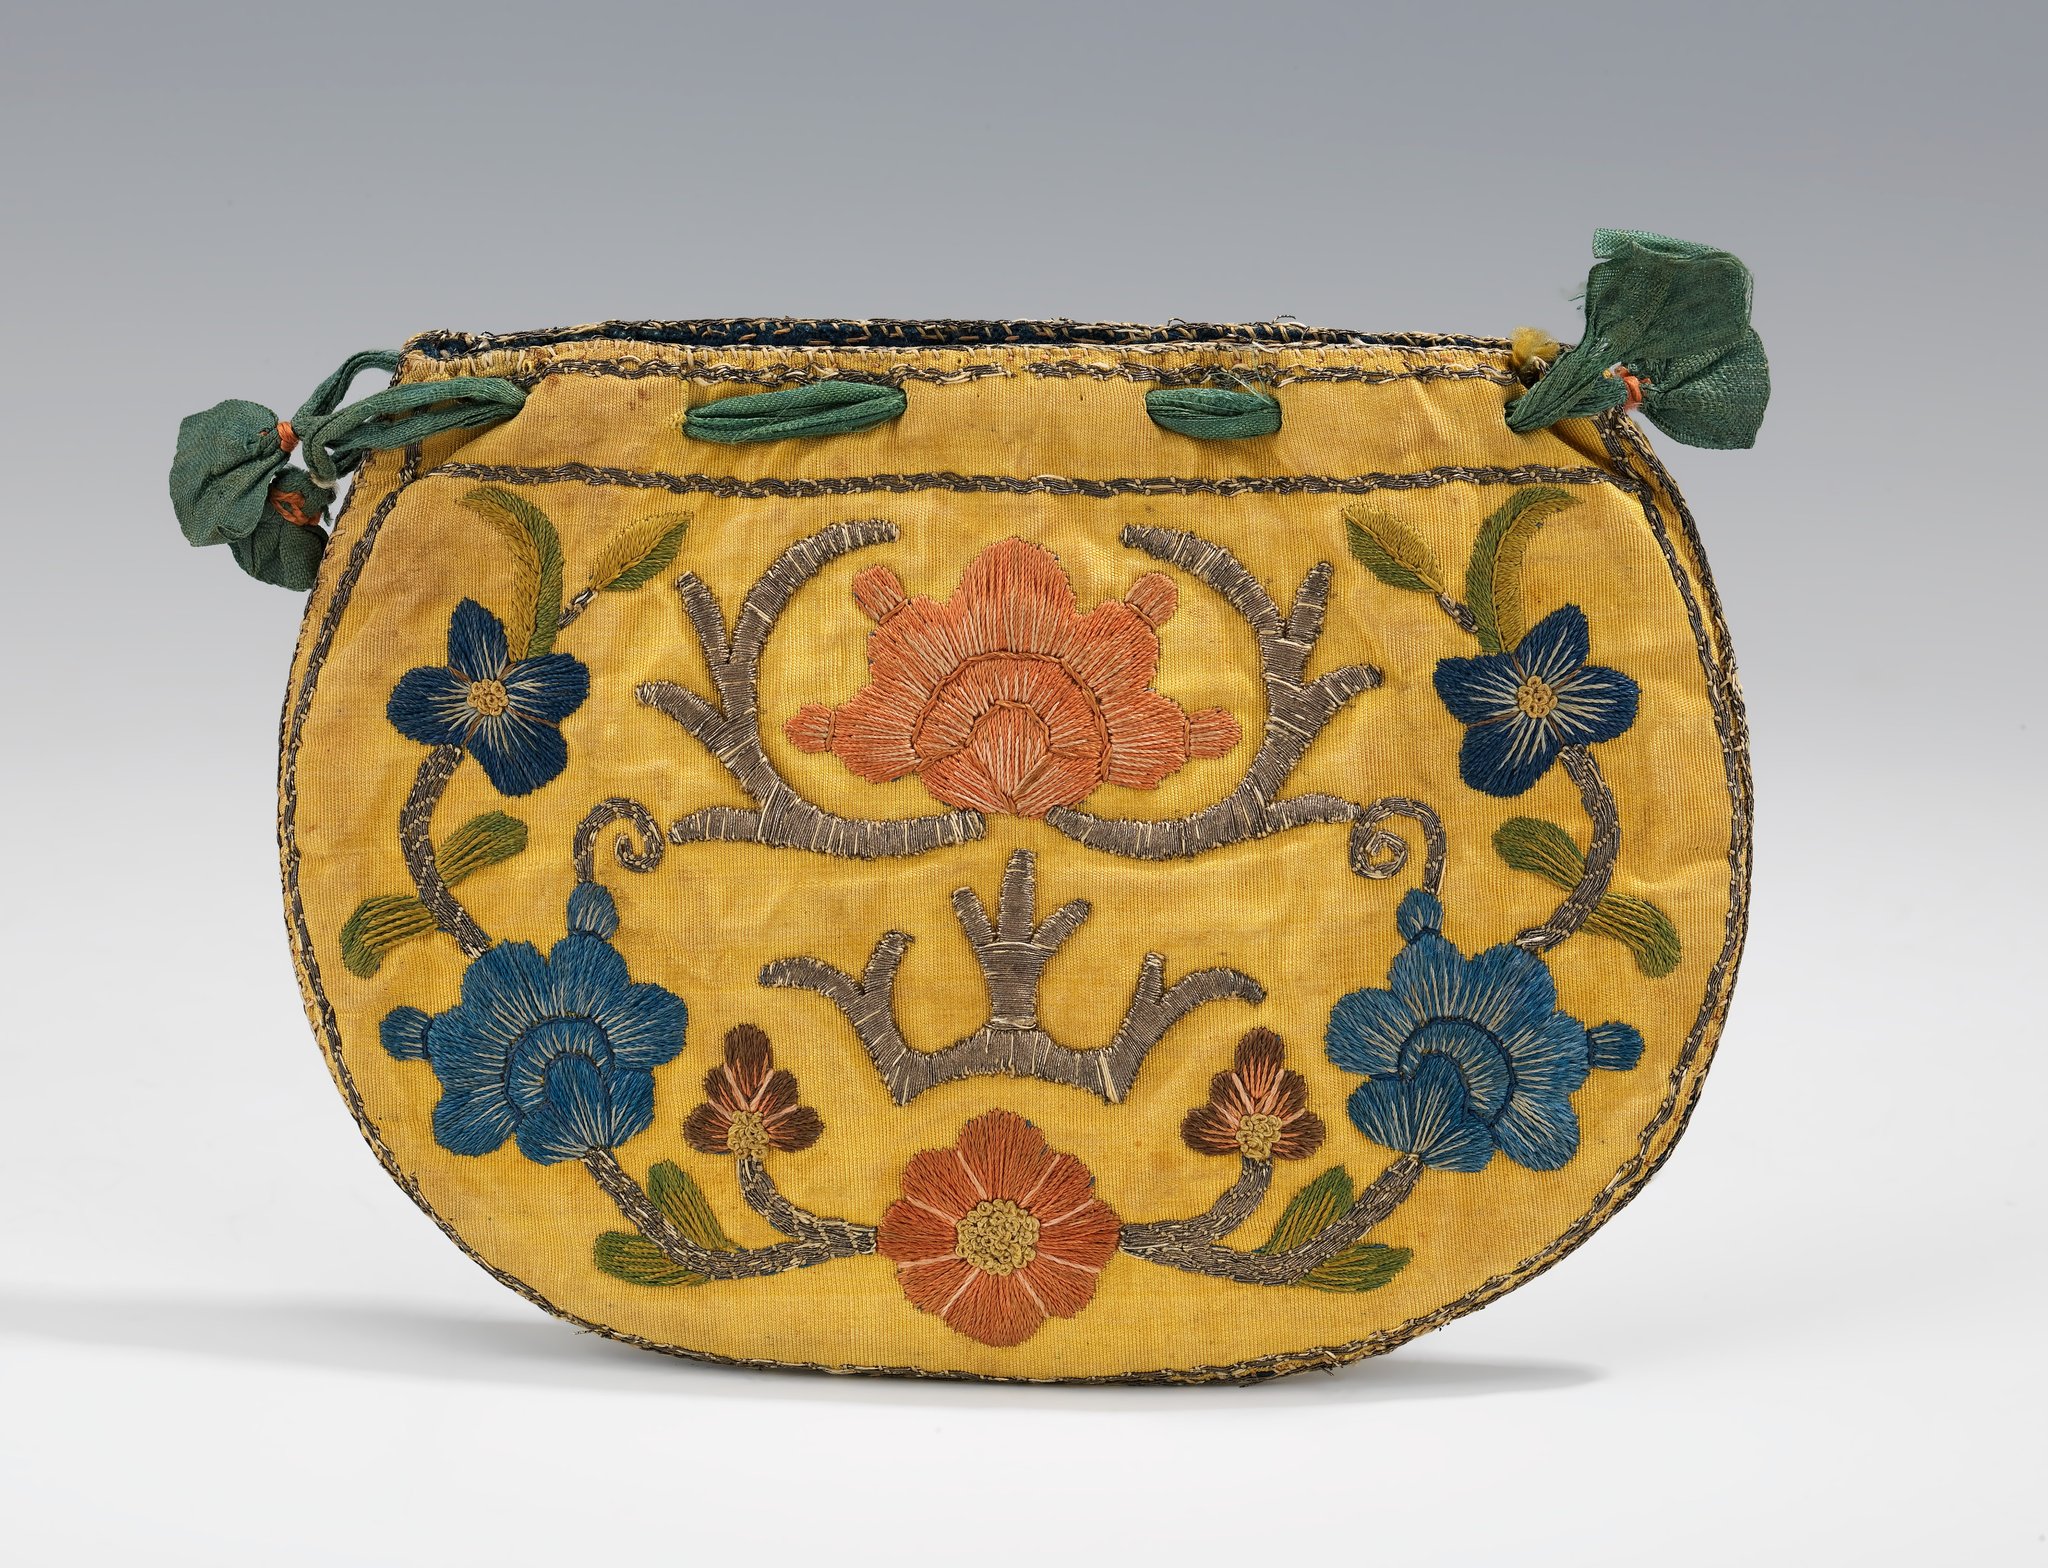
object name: pouch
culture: russian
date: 1740-1770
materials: cotton, metal, silk